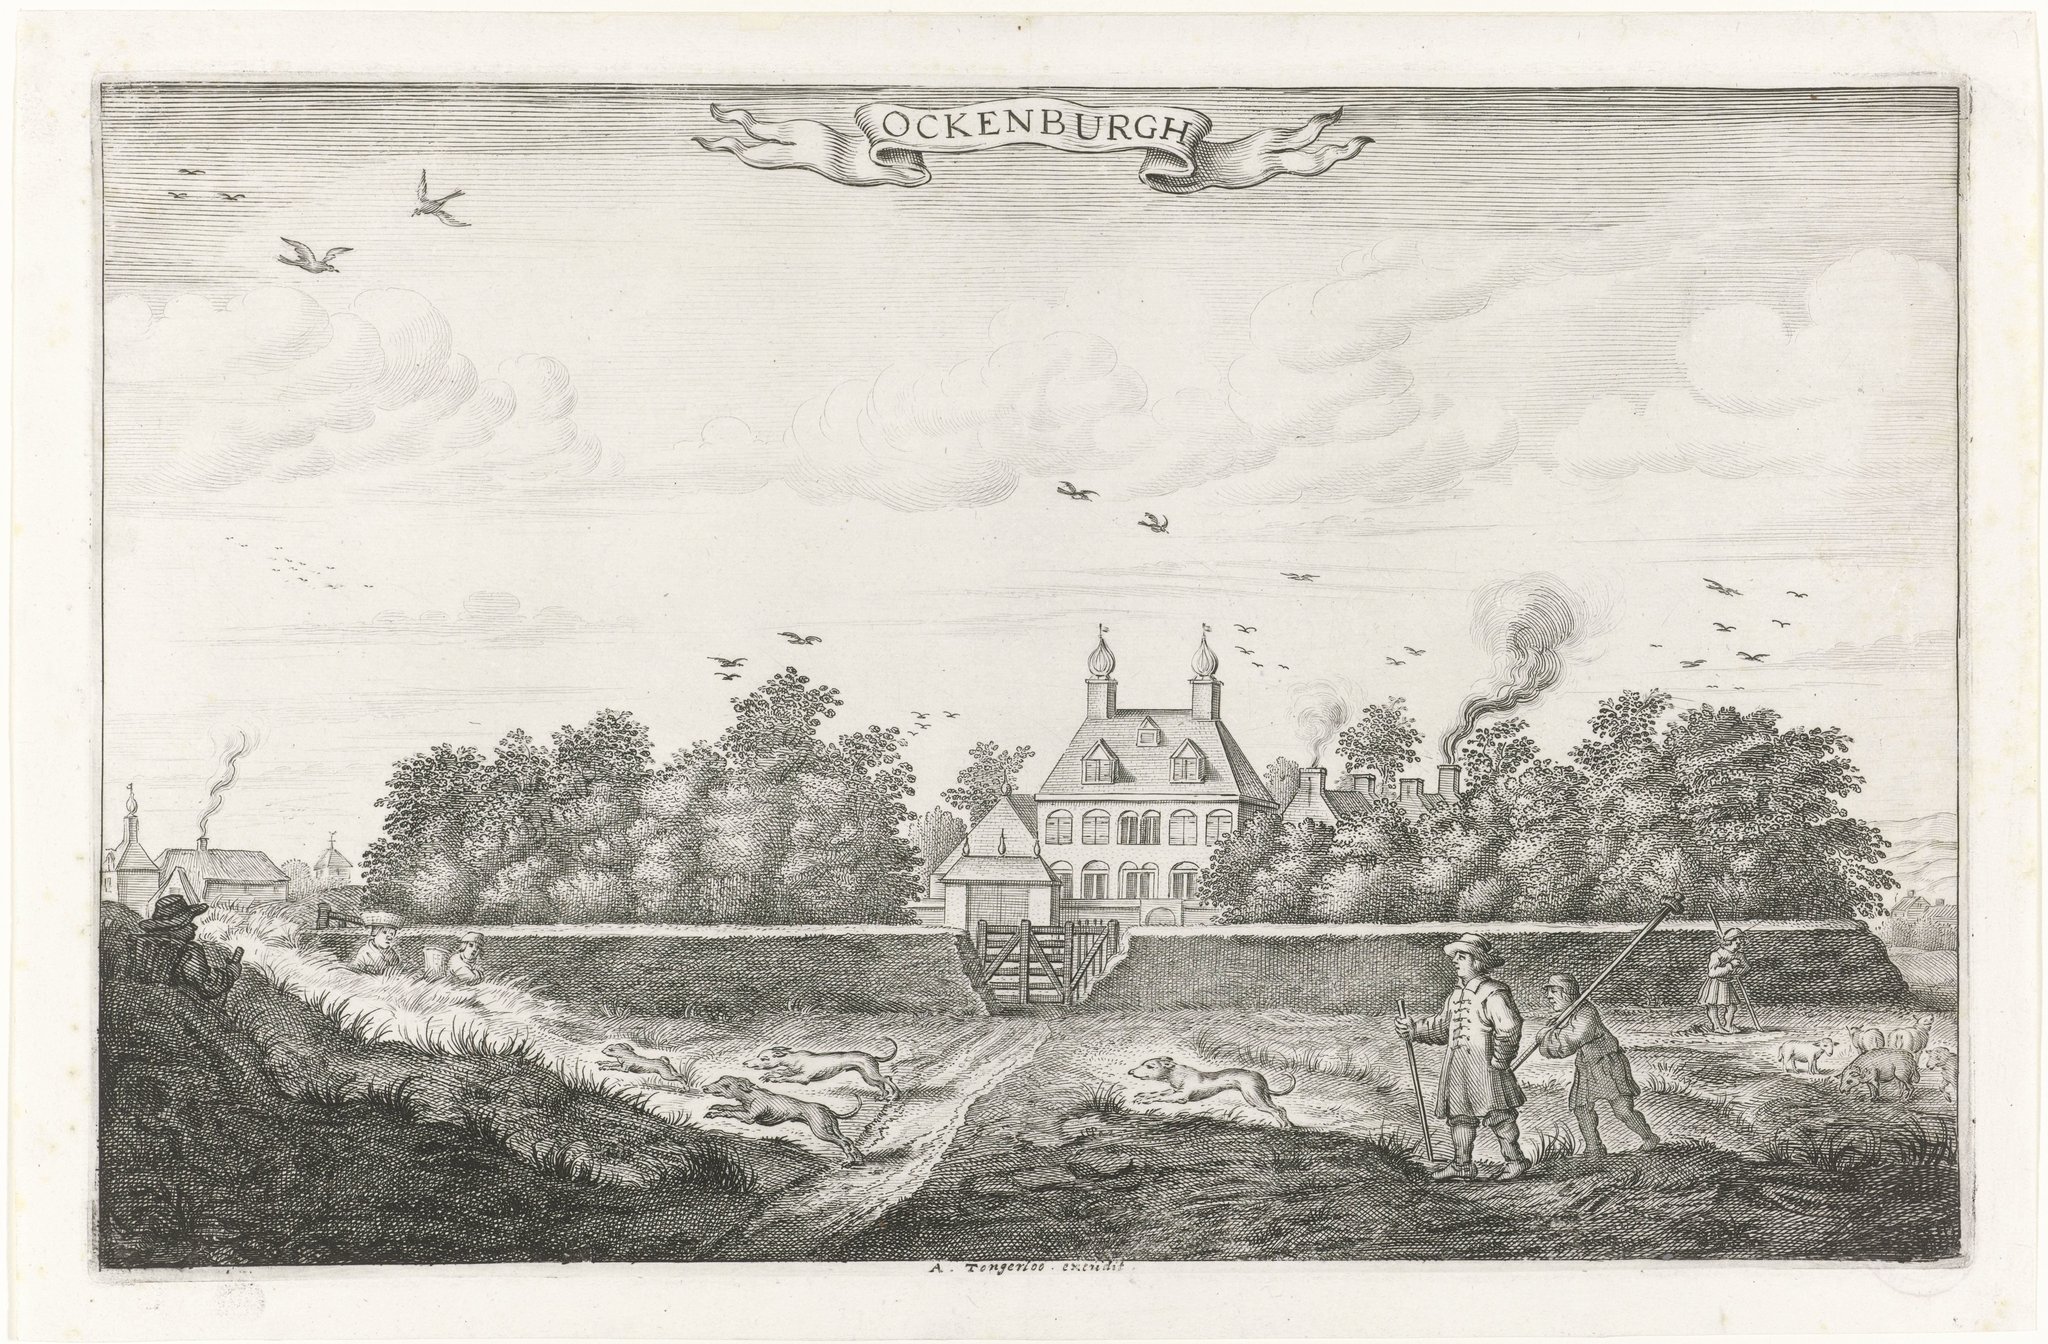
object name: print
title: Ockenburgh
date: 1650-1660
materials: paper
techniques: engraving, etching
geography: the hague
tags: rural housing, e.g. country-house, villa, cottage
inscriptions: collector's mark: Lugt 240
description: Gezicht op het buiten Ockenburgh bij Loosduinen. Op de voorgrond enkele figuren, honden en schapen.